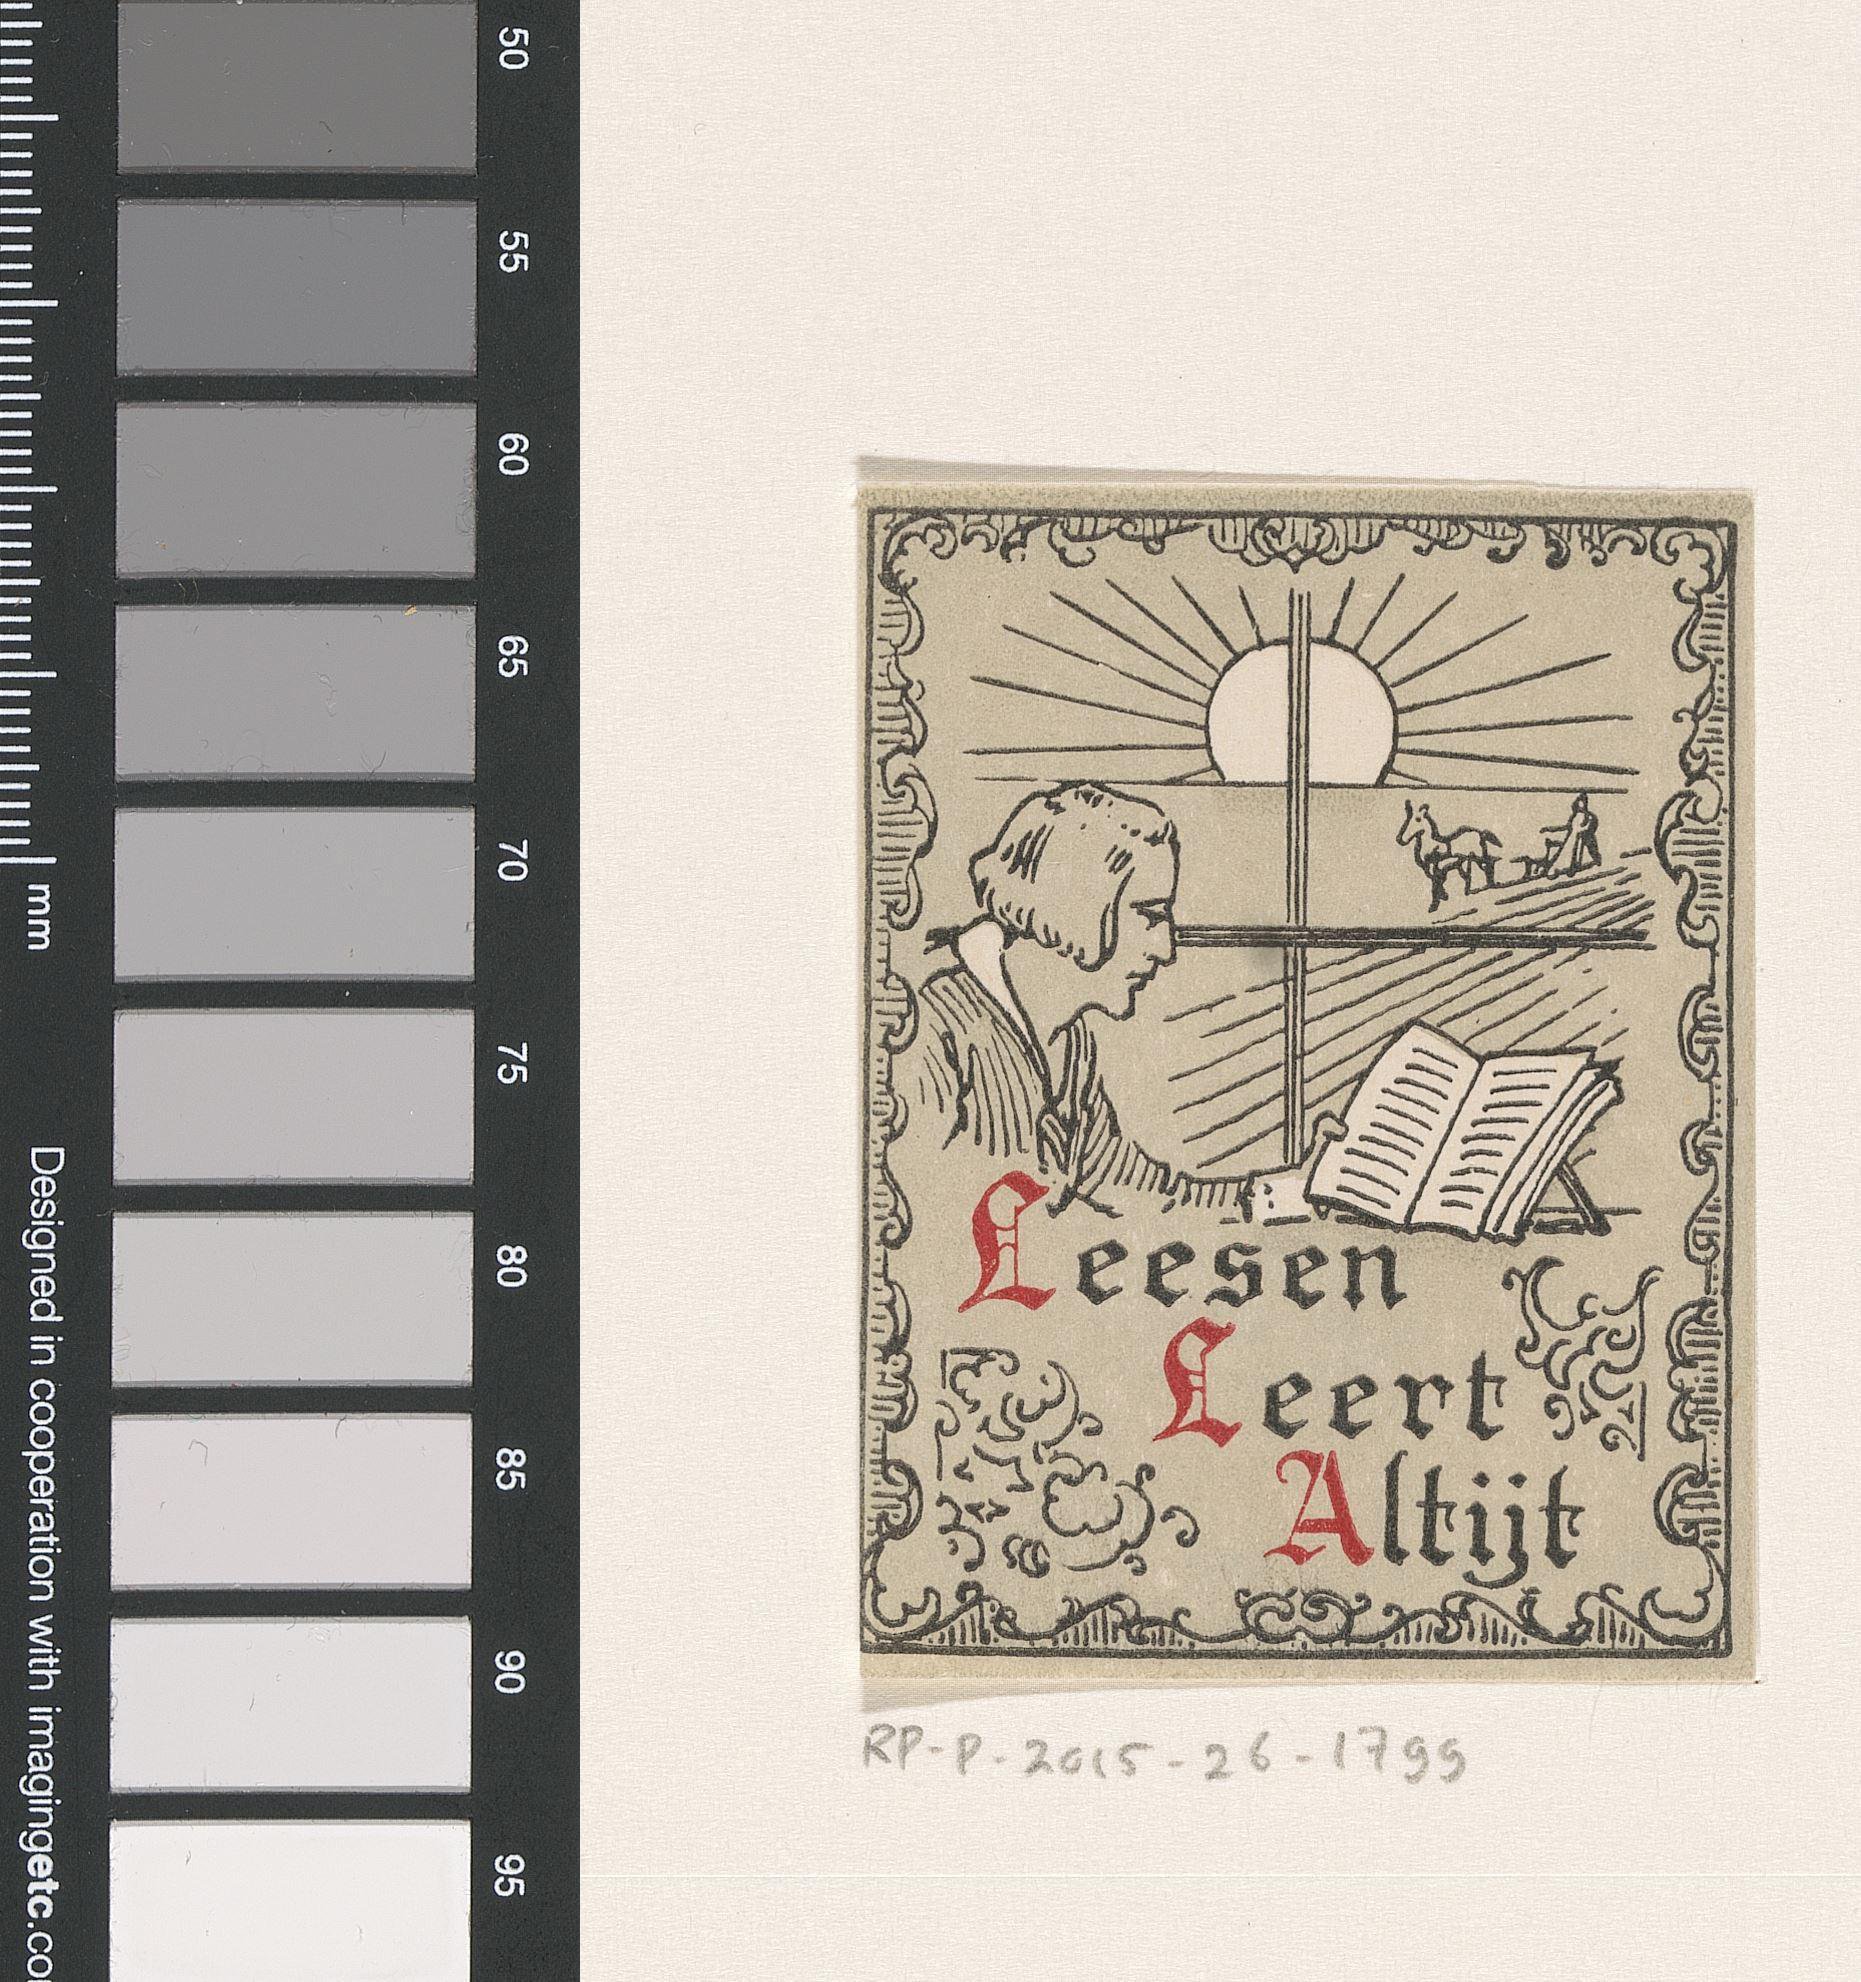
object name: print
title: Ex libris met een lezende man voor een raam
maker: Anonymous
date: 1900-1950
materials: paper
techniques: lithograph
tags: reading, book, sun as celestial body, ploughing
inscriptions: collector's mark: Lugt 2228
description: Het raam biedt uitzicht op een ploegende boer en een opkomende of ondergaande zon. Onder het motto: 'Leesen Leert Altijd'.